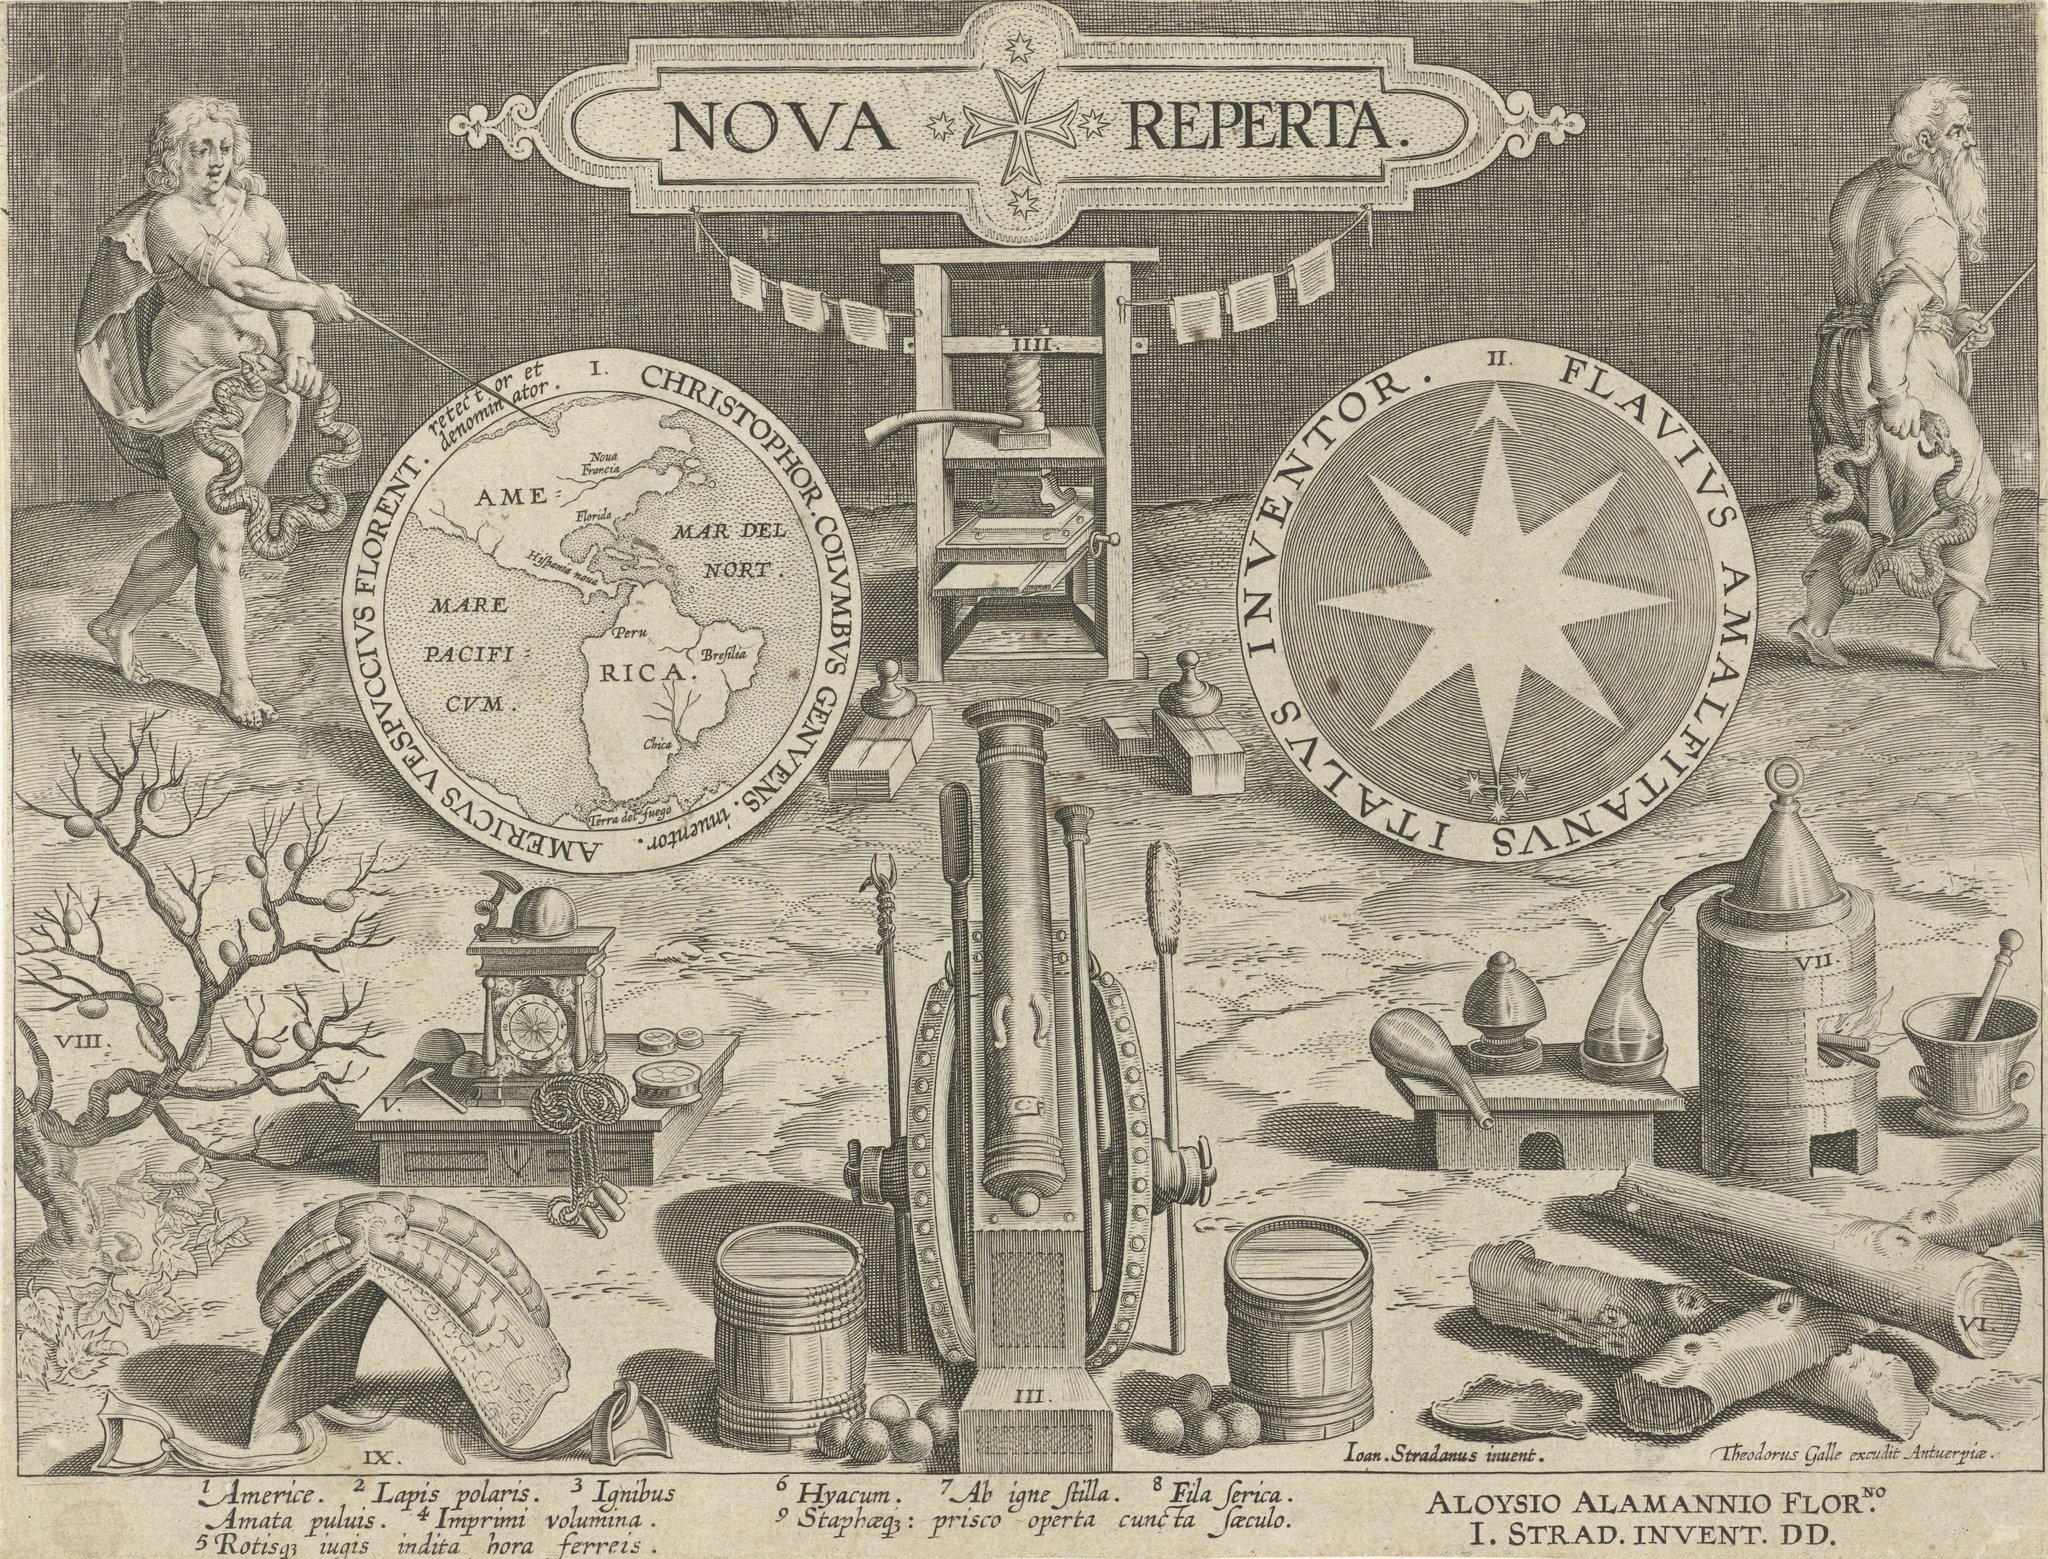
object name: titelprent, frontispice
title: Titelprent voor de serie Nova Reperta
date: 1589-1593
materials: paper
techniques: engraving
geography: antwerp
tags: saddle and bridle (saddlery), projectiles, explosives, etc.: gunpowder, printing press, clock, firearms: cannon, laboratory apparatus and equipment, compass, medicament, medicine, invention, discovery ~ science and technology, (map of) america, things unknown, the unknown, things known, the known, silkworm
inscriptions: collector's mark: Lugt 2228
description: Centraal boven een cartouche met de titel van de prentserie. Onder de cartouche de drukpers. Links bovenaan een ronde kaart van het continent Amerika. Een halfnaakte jonge vrouw (ev. Nieuwe Tijden) met de slang Ouroboros wijst met een aanwijsstok naar Noord-Amerika. Rechts bovenaan een kompasroos en een oudere man (ev. Oudheid) met de slang Ouroboros. Op de voorgrond voorwerpen die symbool staan voor de nieuwe uitvindingen van de zestiende eeuw: de zijdeworm, een zadel en sporen, een mechanisch uurwerk, een kanon en buskruit, een medicinale plant en distilleerapparatuur. De prent heeft een Latijnse legende en maakt deel uit van een serie over nieuwe uitvindingen en ontdekkingen.